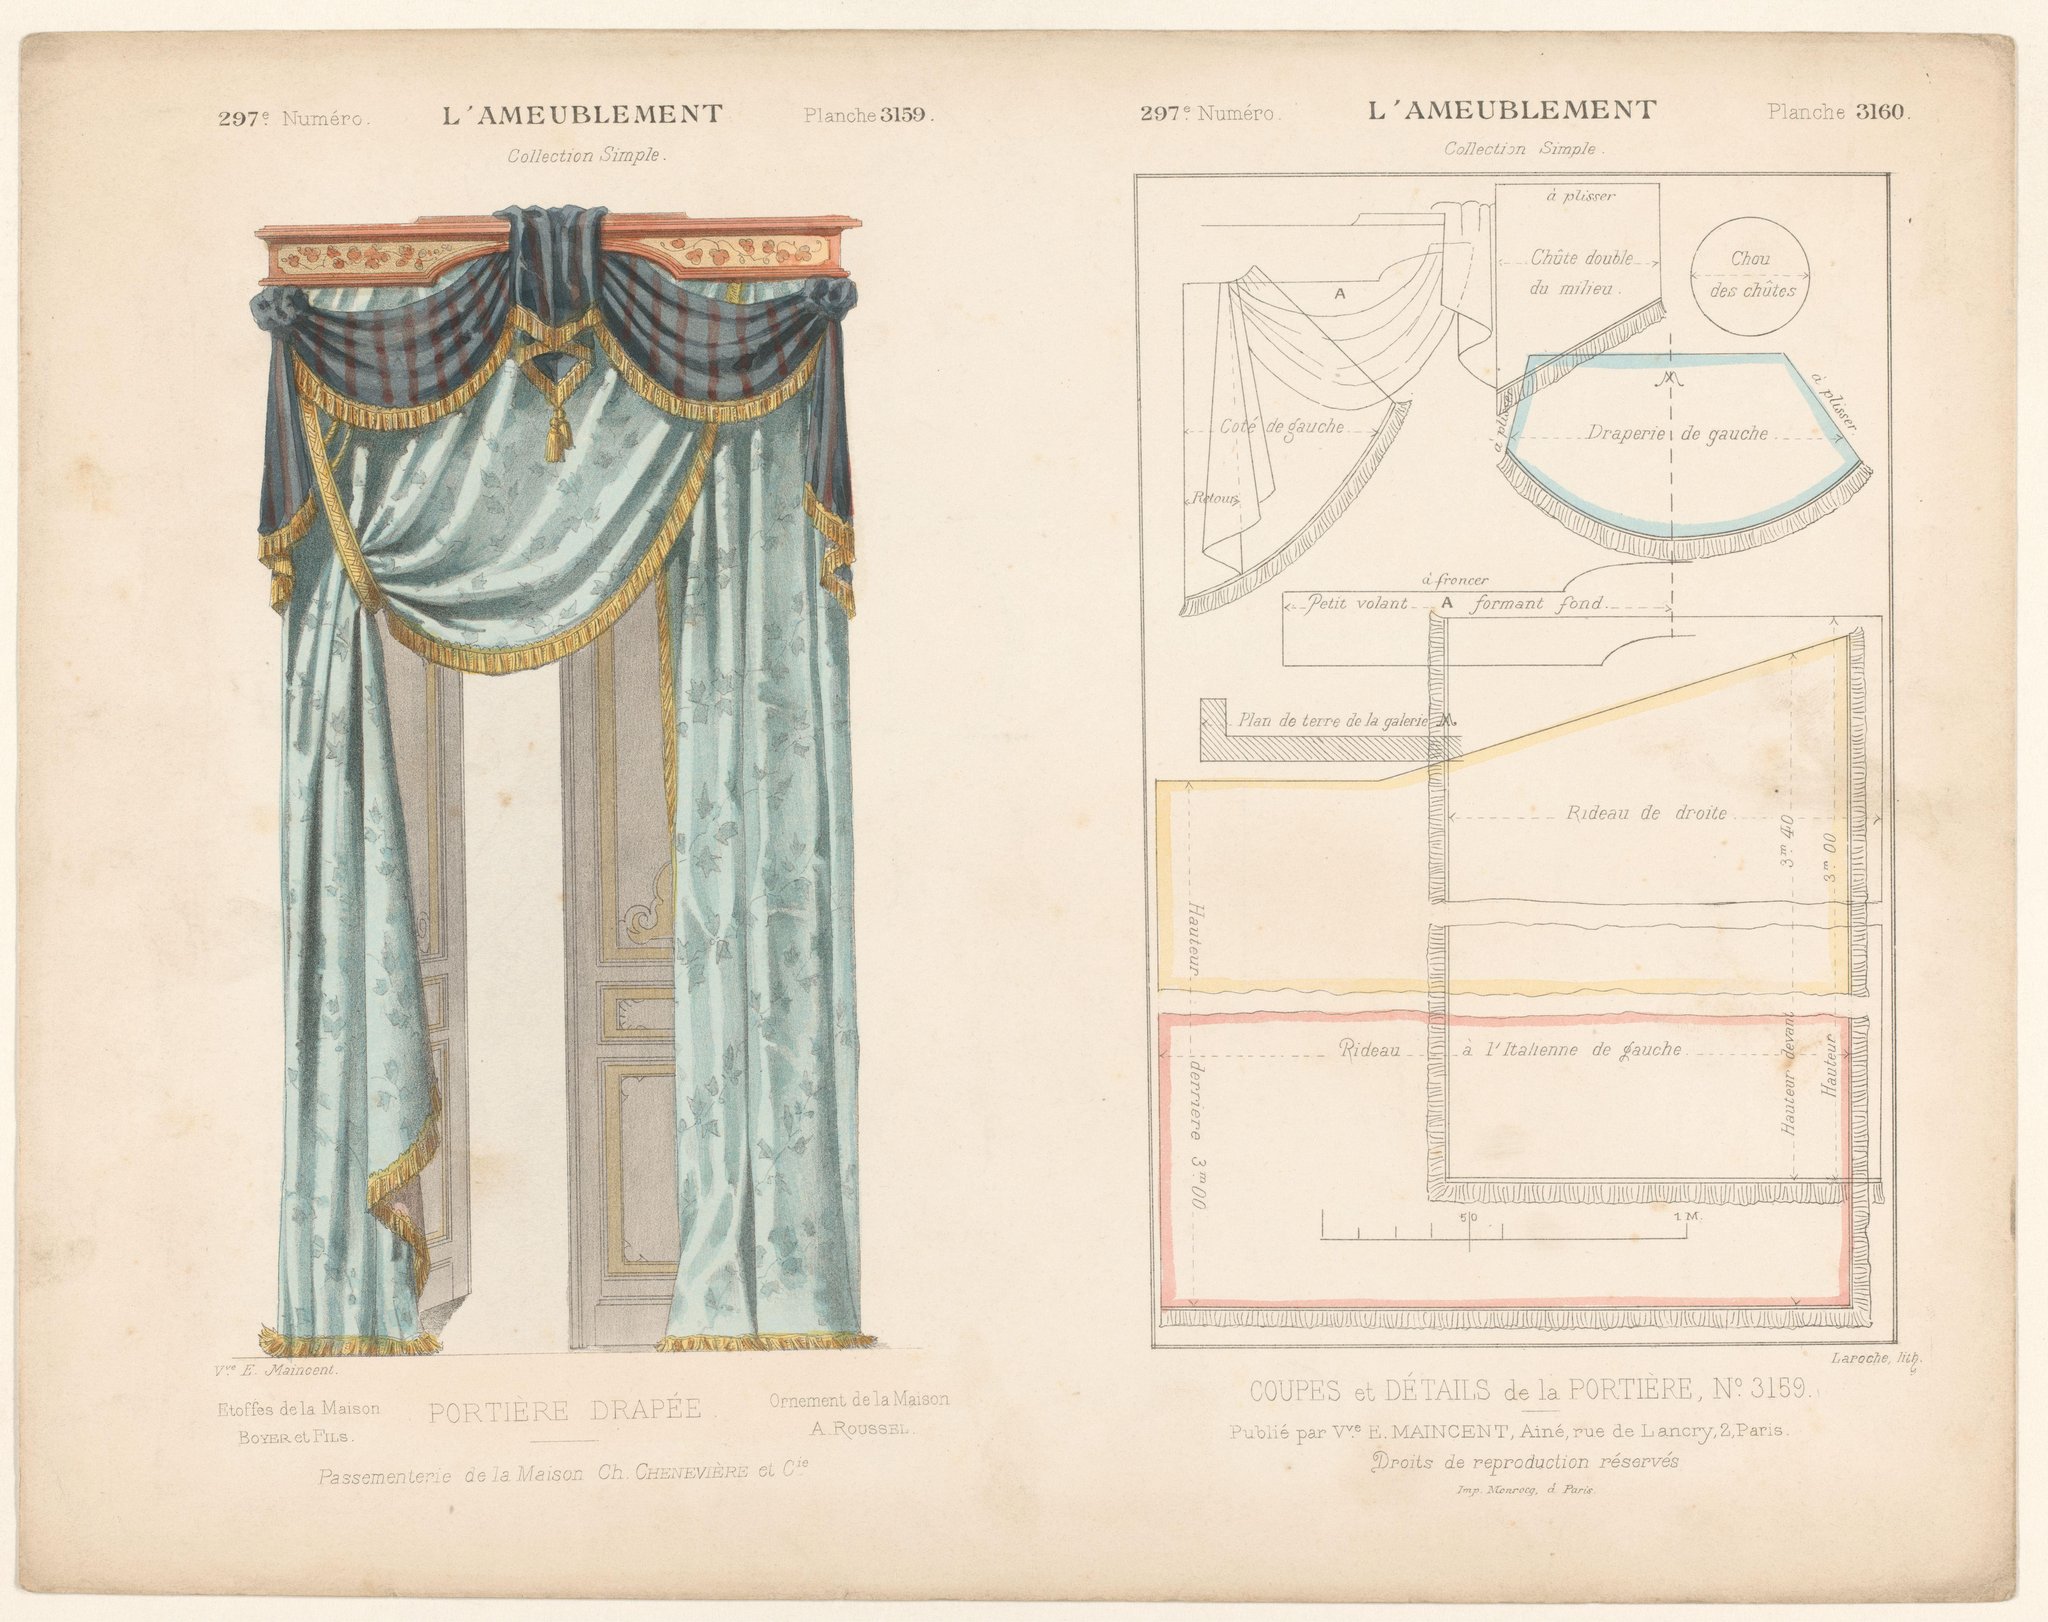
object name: print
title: Portière drapée / Coupes et détails de la portière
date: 1895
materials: paper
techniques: hand coloring, lithograph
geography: paris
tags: door, hangings and drapery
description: Een deur met gedrapeerde gordijnen. Rechts details van de draperieën. Prent uit 296e Livraison.